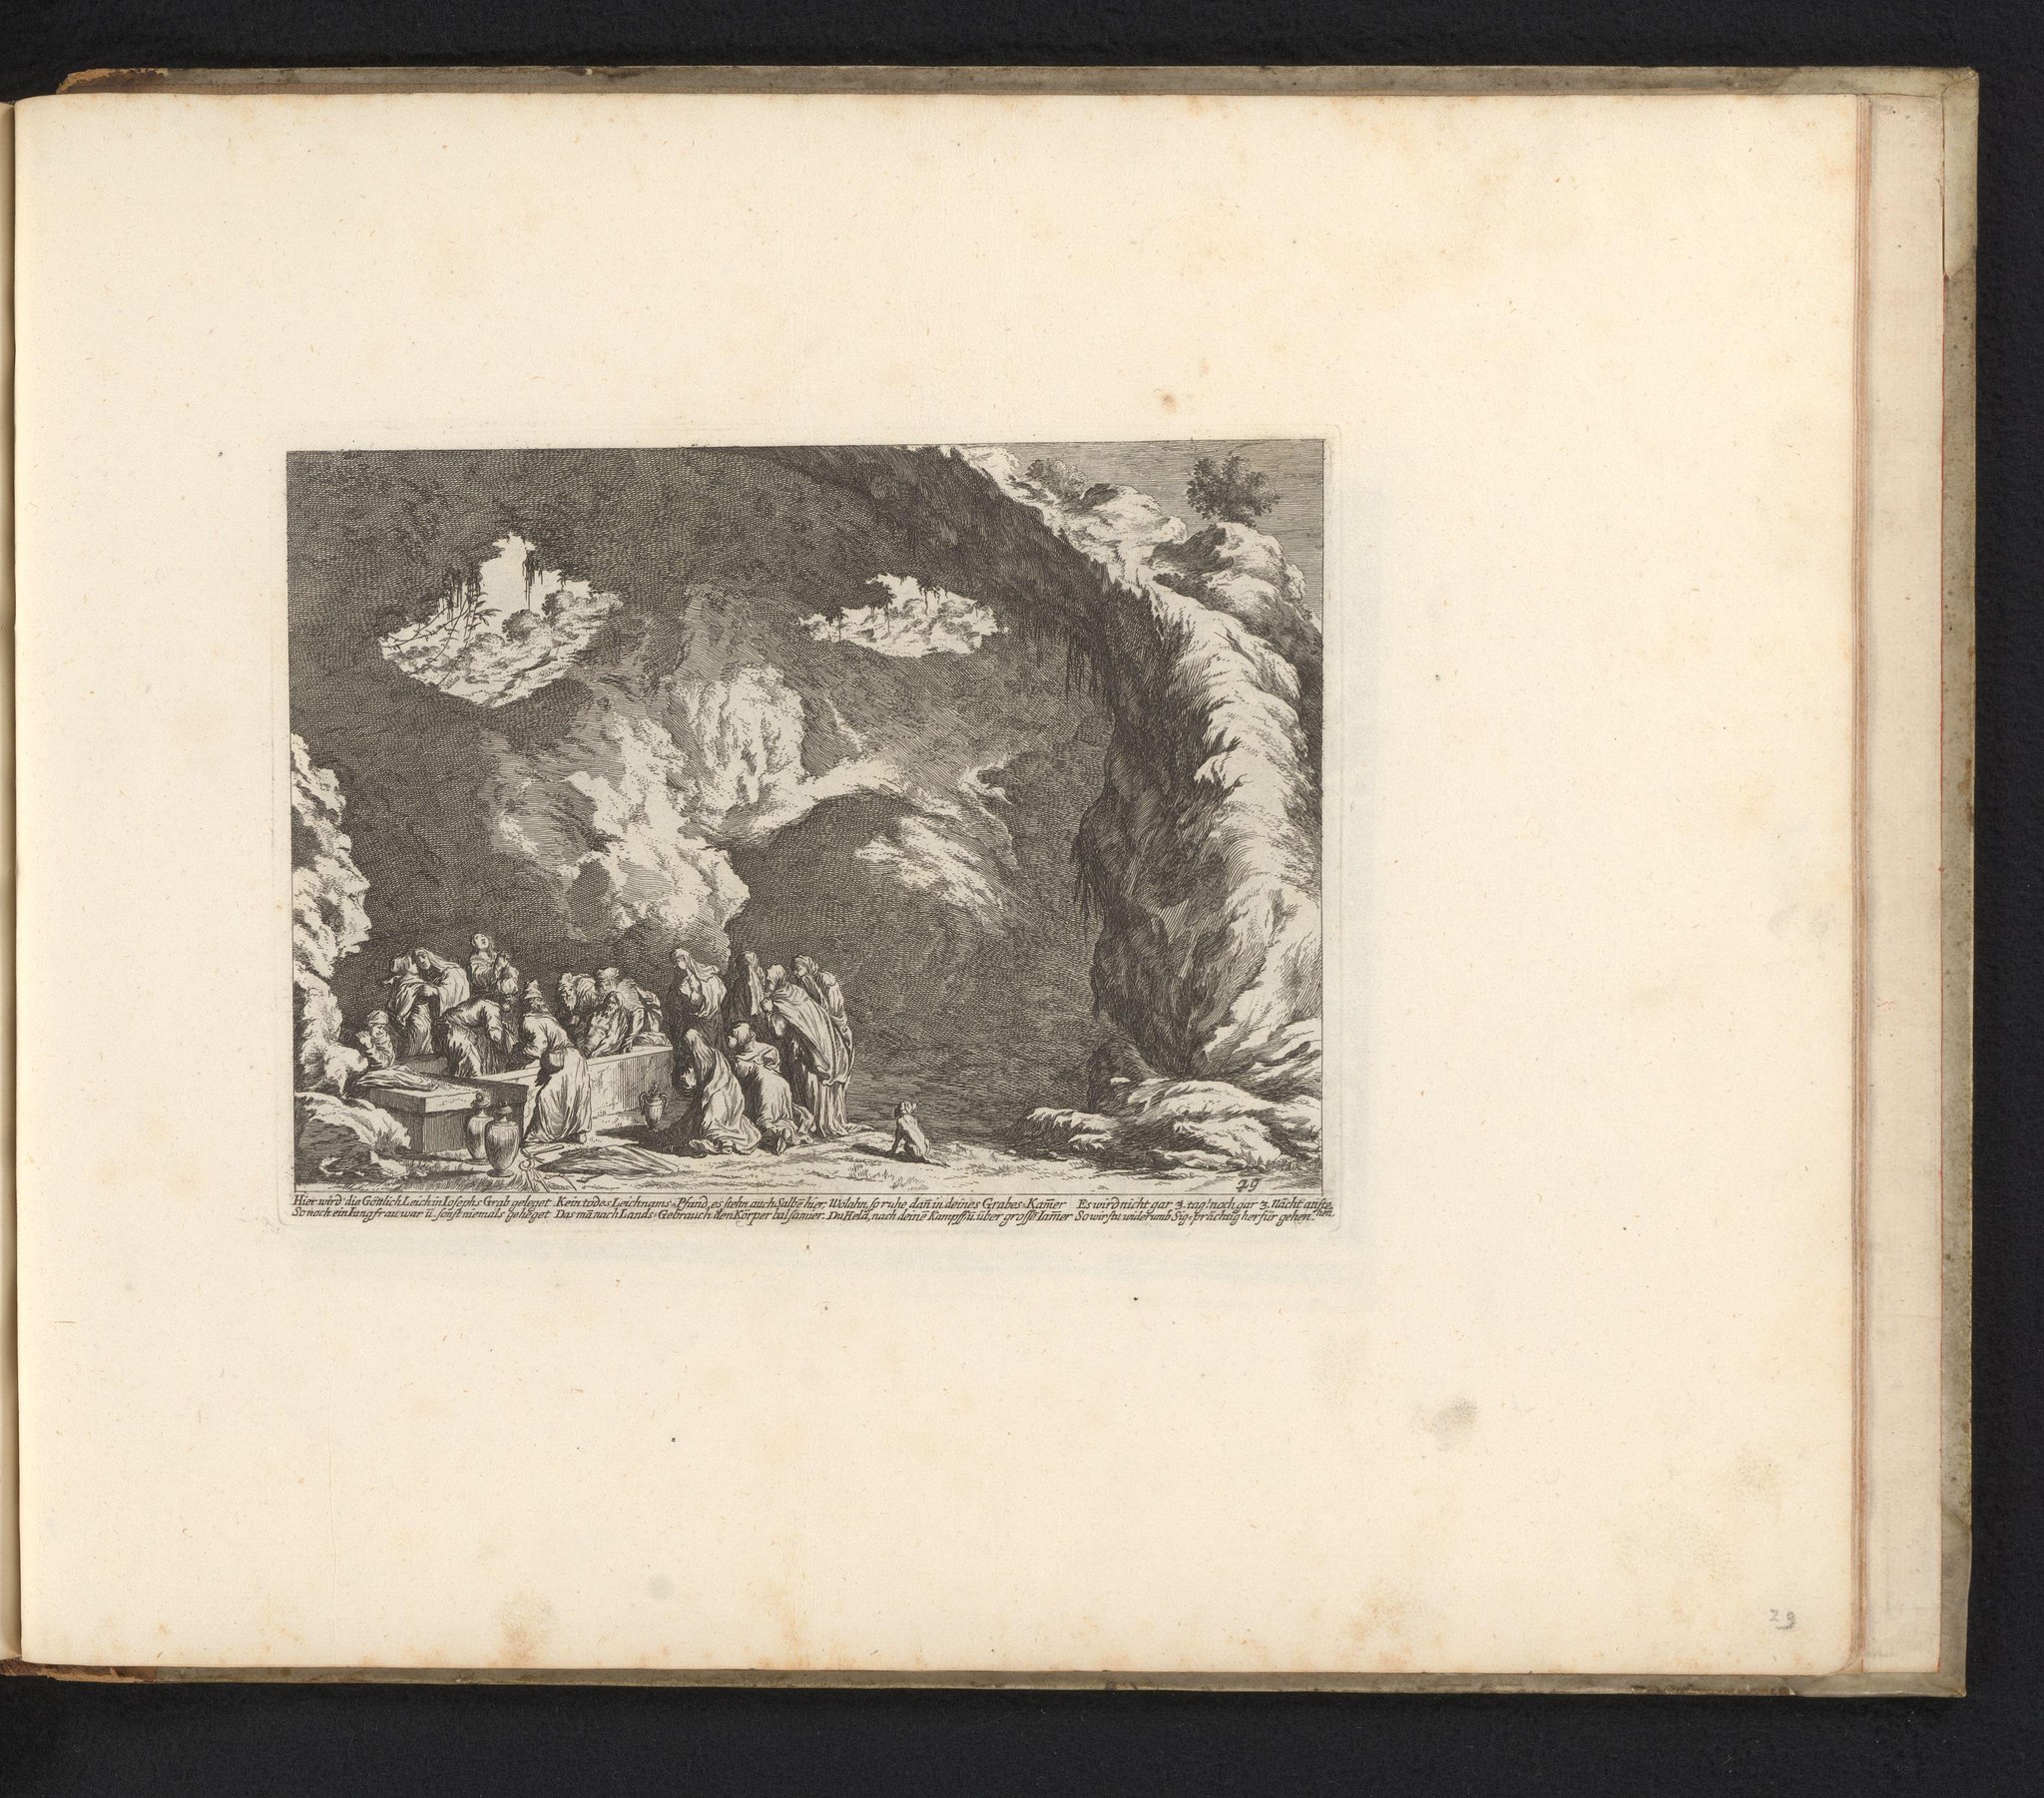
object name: album leaf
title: Graflegging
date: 1670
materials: paper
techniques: etching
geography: augsburg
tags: christ lying in the sarcophagus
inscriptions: collector's mark: Lugt 2228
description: Tekst in het Duits in de ondermarge. Rechtsonder genummerd: 29. Prent maakt deel uit van een album.